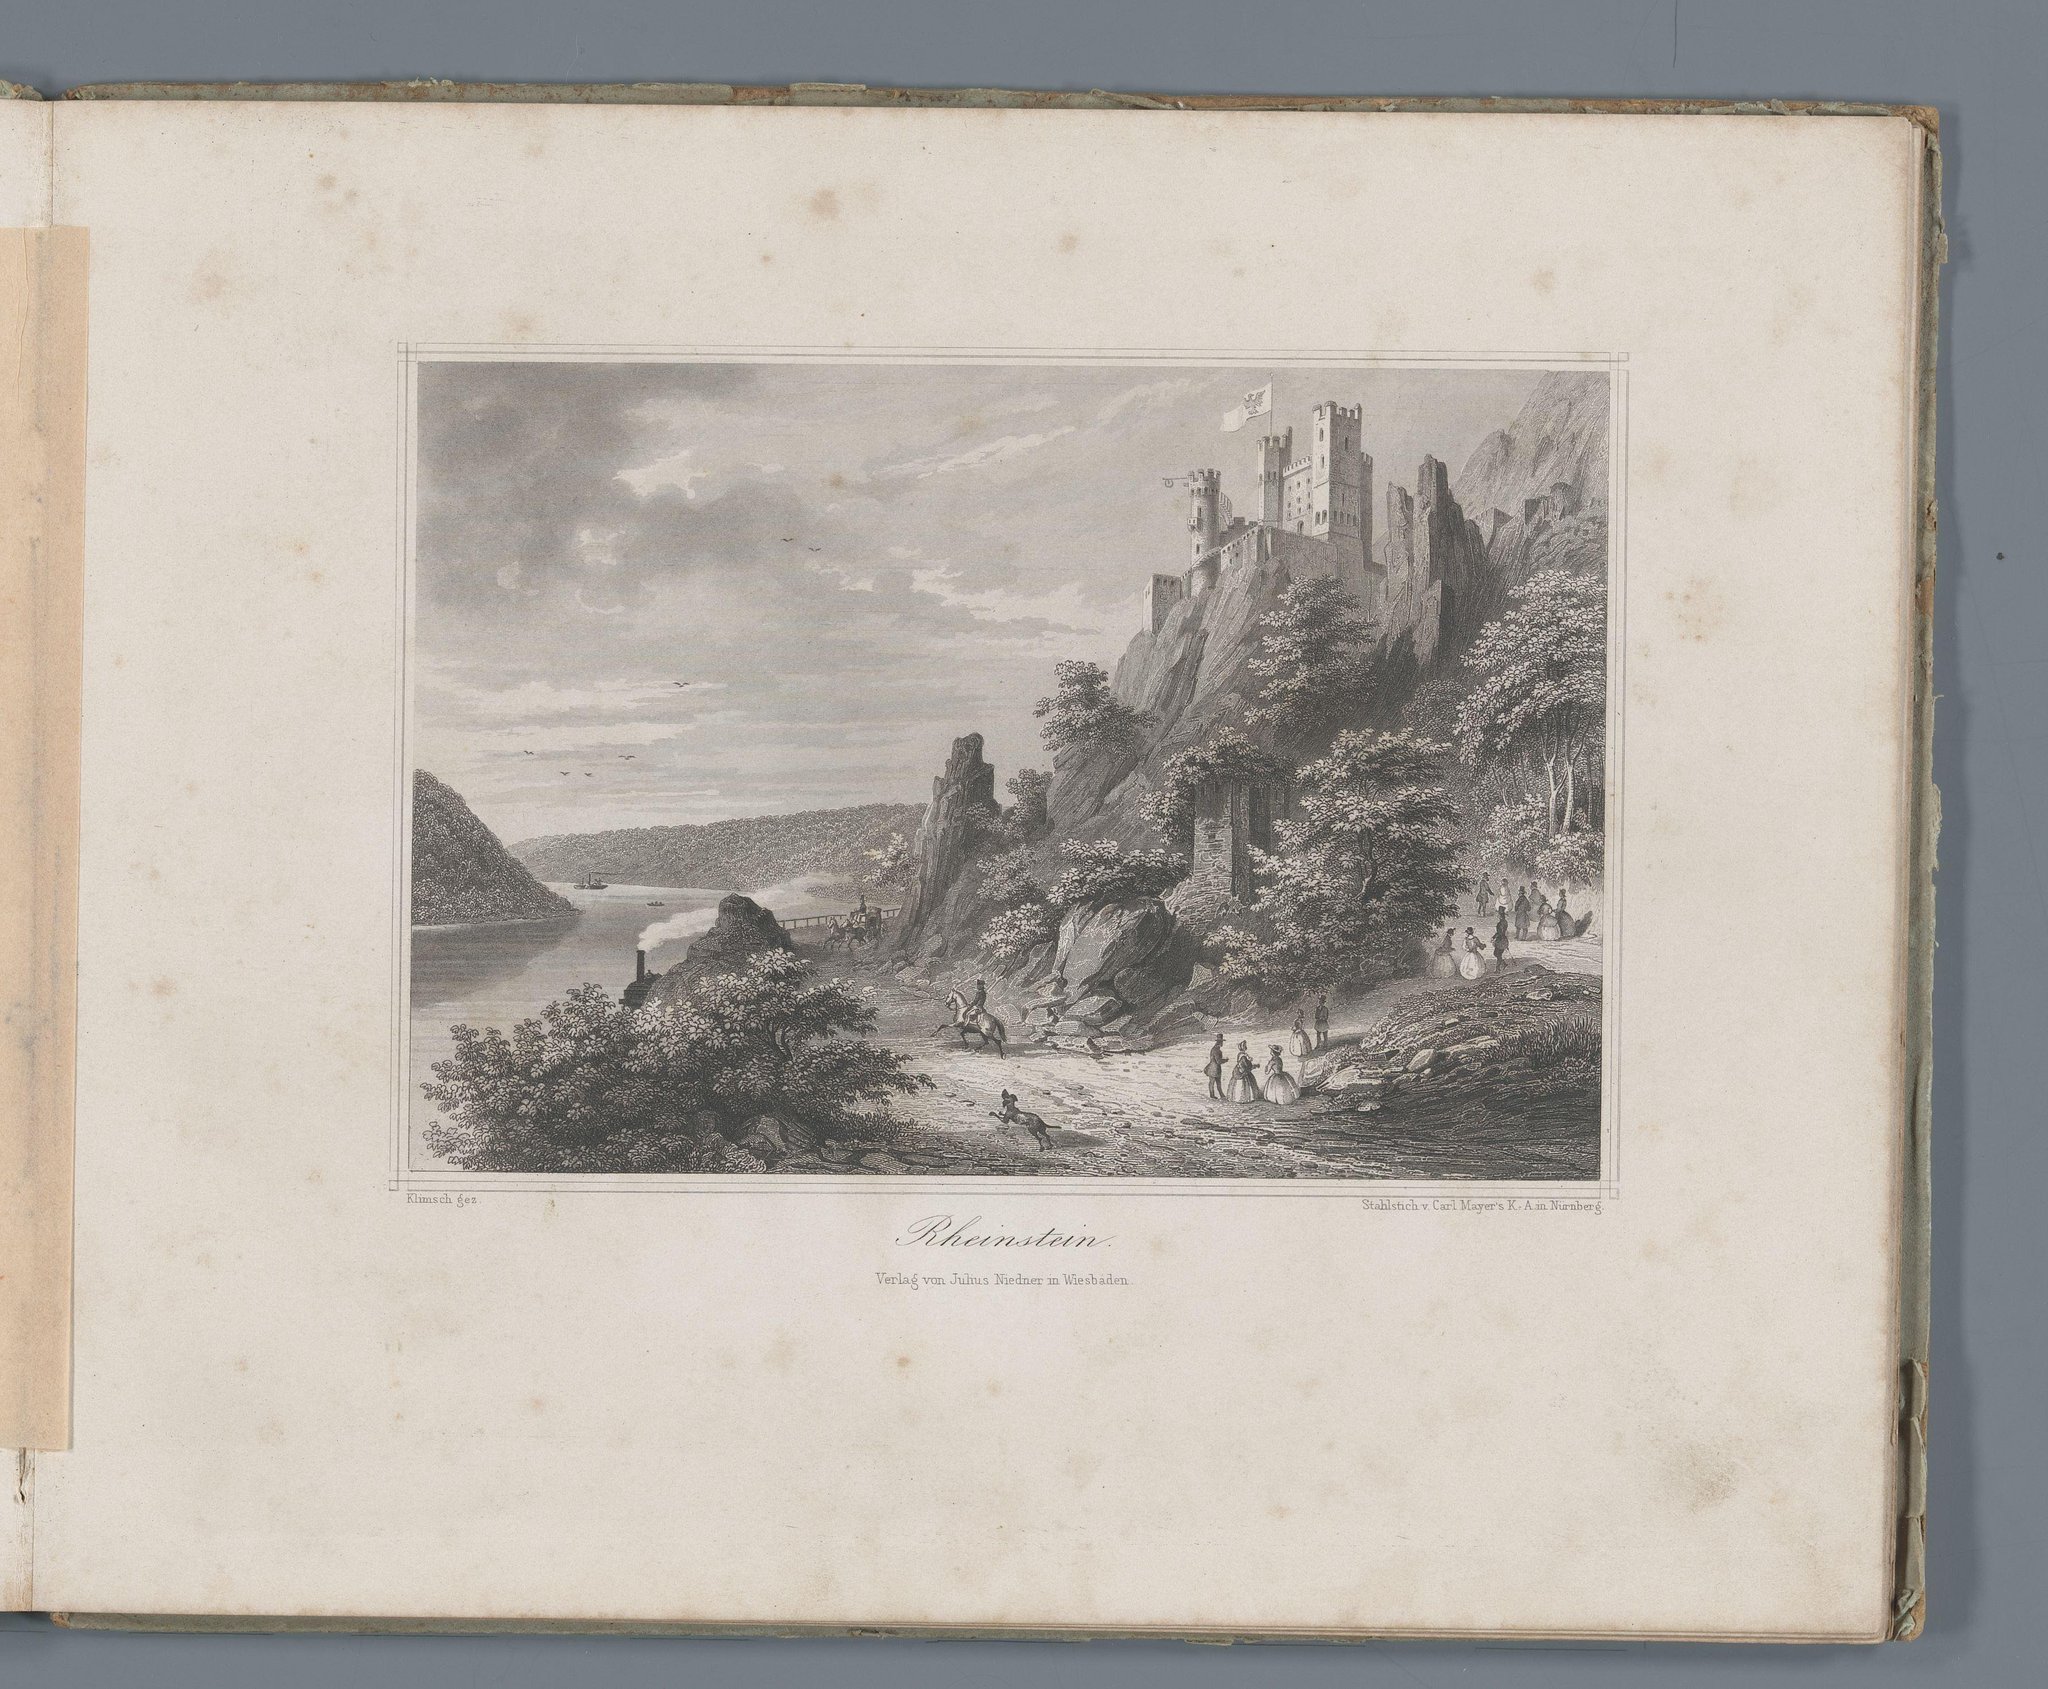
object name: print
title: Zwölf der schönsten Ansichten des Rheins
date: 1822-1868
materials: paper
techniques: engraving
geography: nuremberg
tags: castle, river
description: Deze prent maakt deel uit van een album met twaalf prenten.